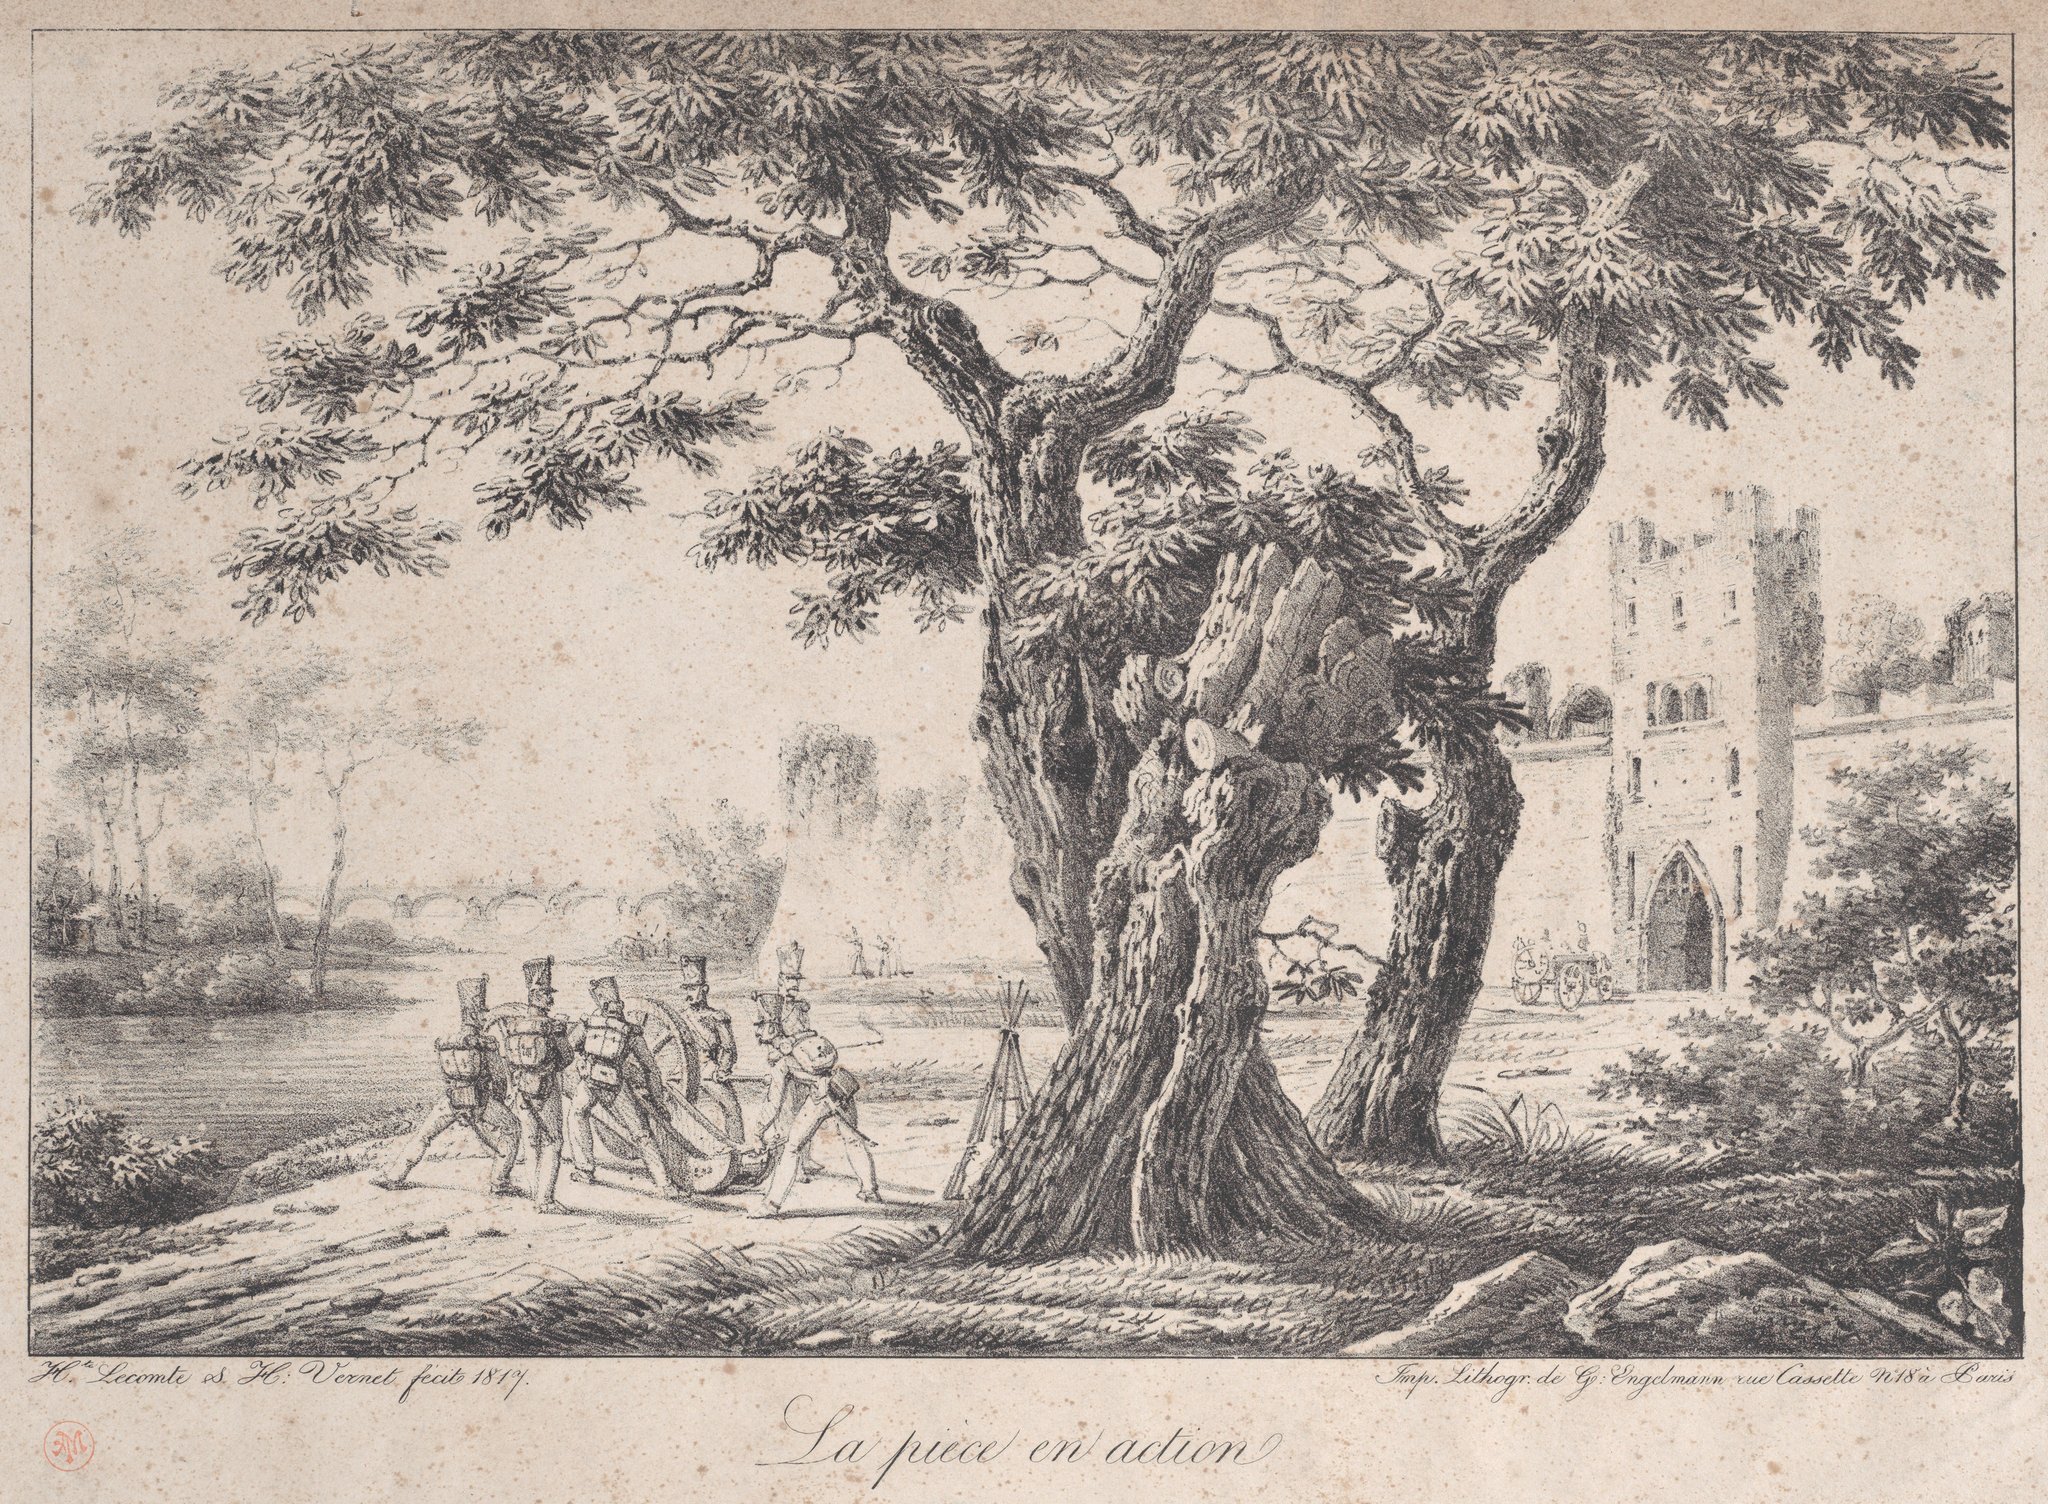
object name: print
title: The Group in Action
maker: horace vernet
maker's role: artist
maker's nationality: french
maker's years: 1789-1863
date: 1817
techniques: lithograph